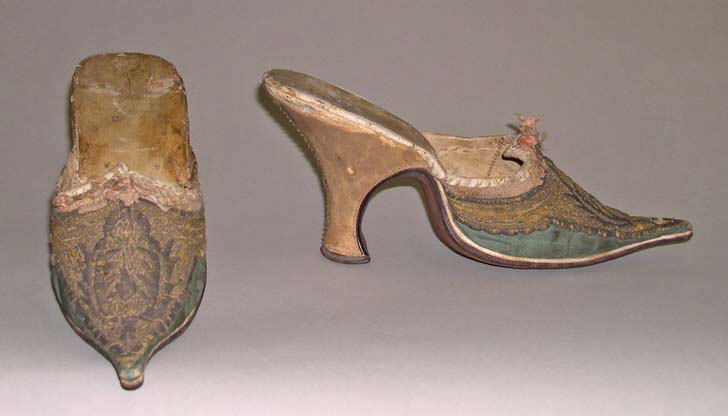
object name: mule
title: Mules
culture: french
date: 1710-1729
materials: leather, silk